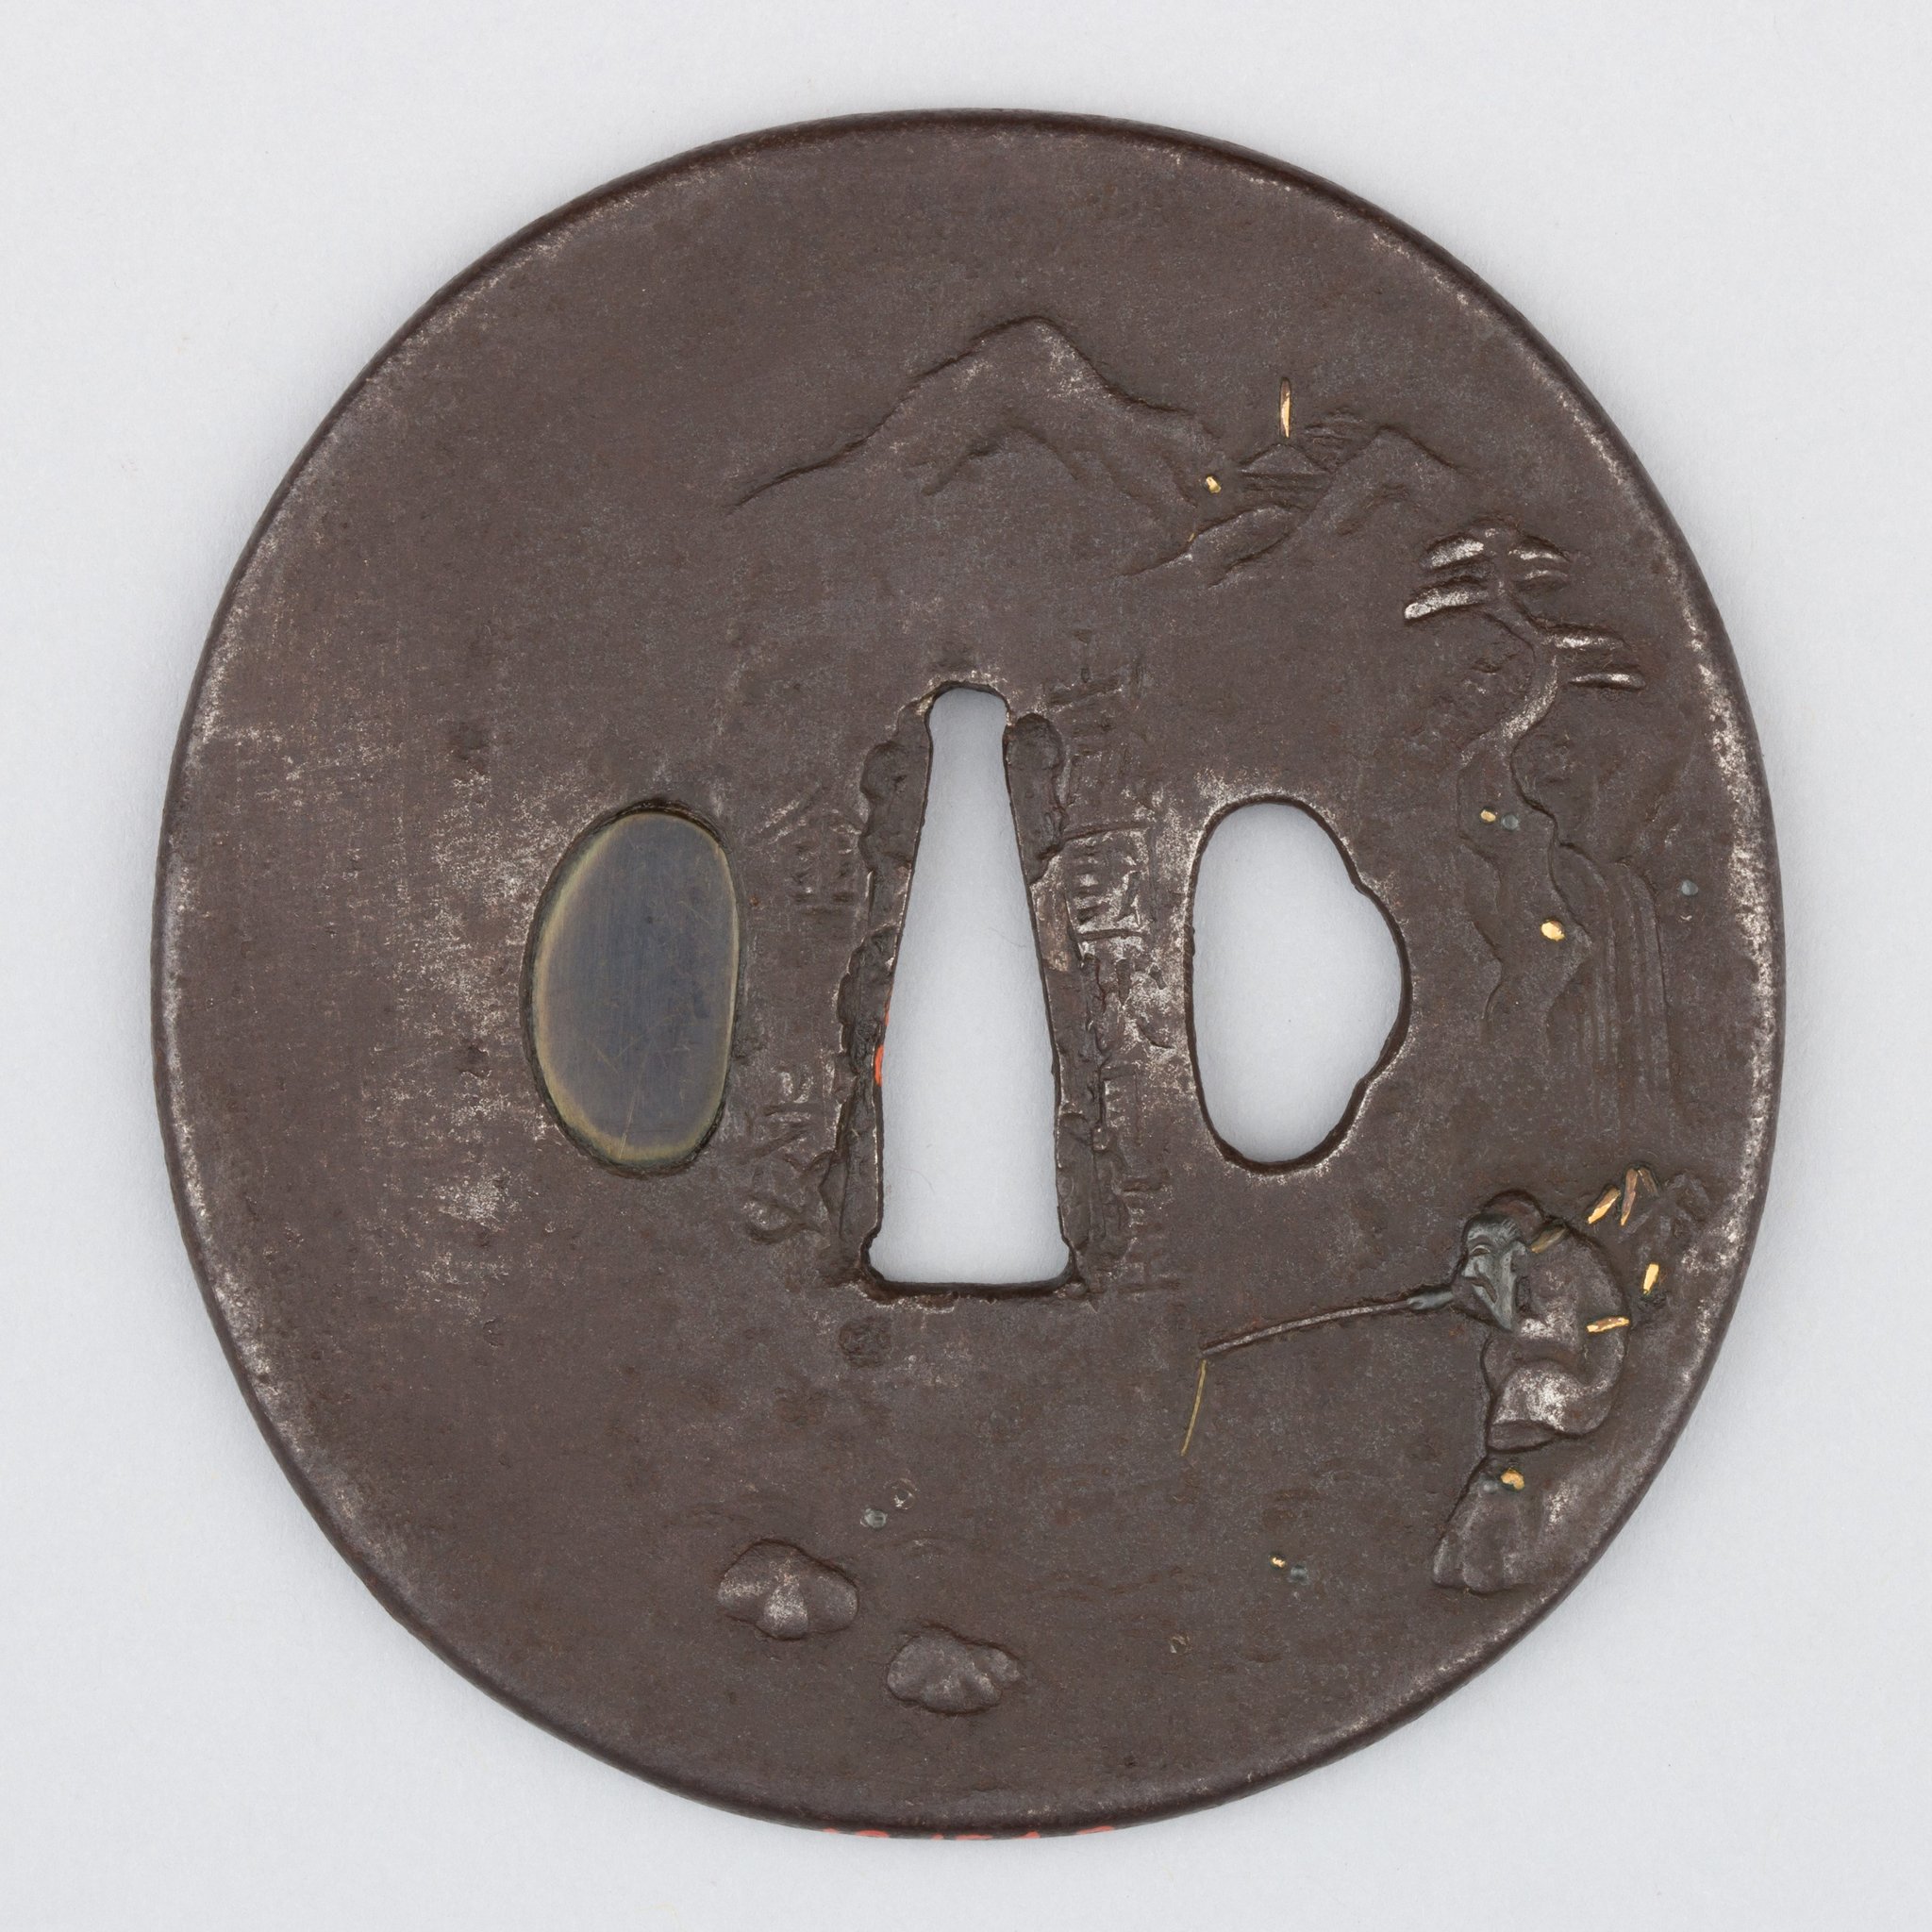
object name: sword guard tsuba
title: Sword Guard (Tsuba)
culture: japanese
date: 1615-1868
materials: copper, gold alloy, gold, iron, silver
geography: japan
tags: men,fishing